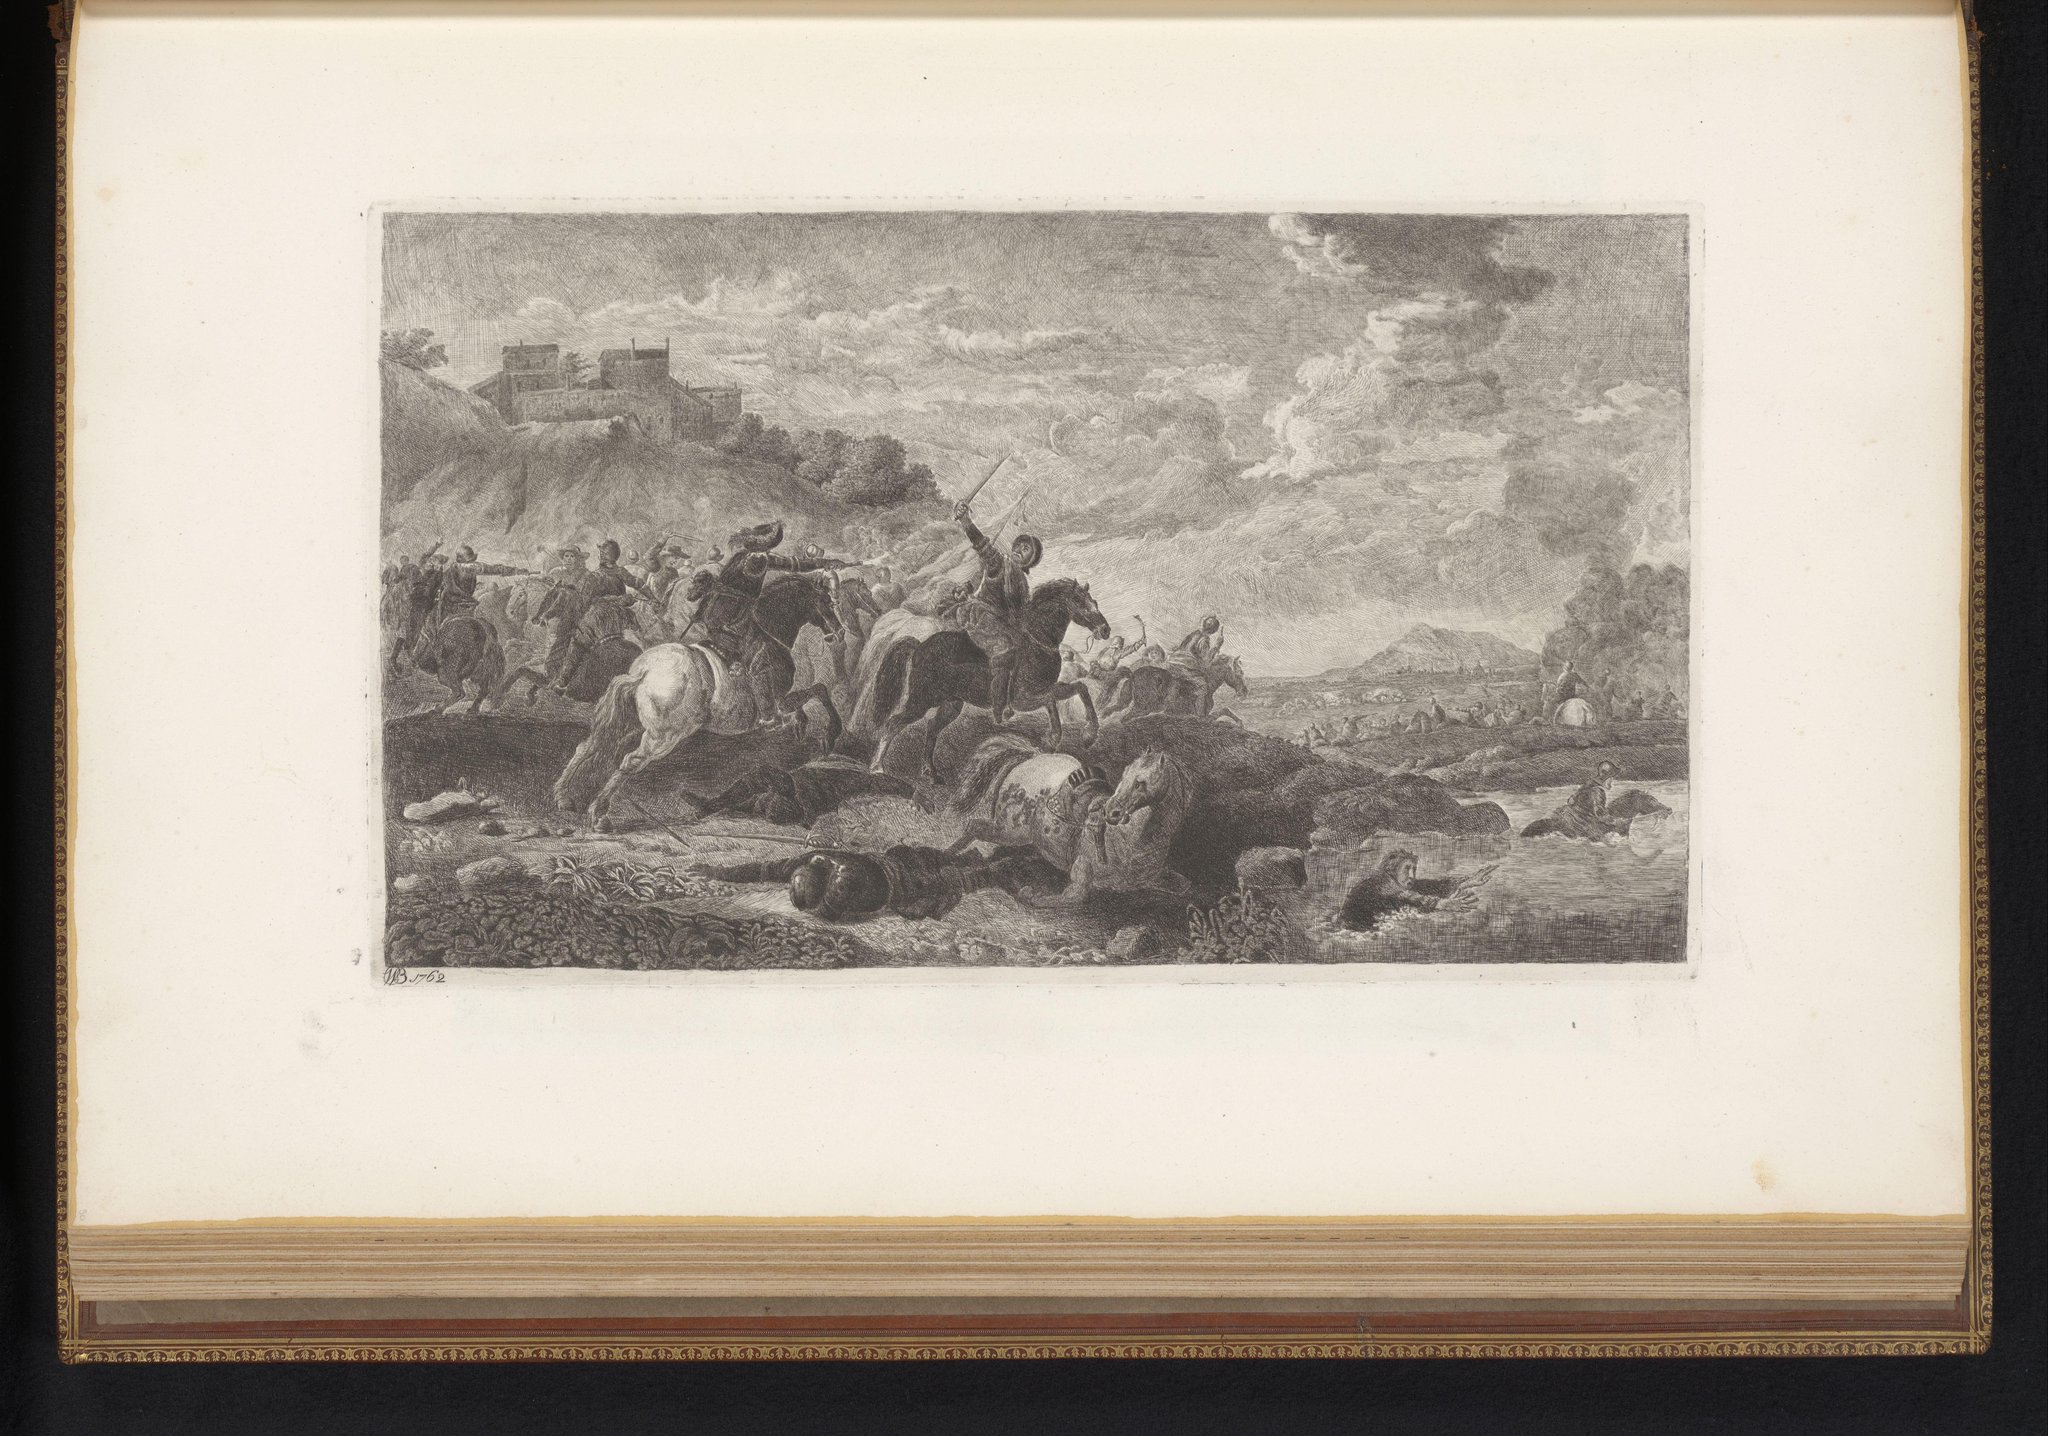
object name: album leaf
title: Cavalerie in gevecht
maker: william baillie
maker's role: print maker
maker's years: 1723-1810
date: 1762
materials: paper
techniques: drypoint, etching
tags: war and peace (+ cavalry, horsemen)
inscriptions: date